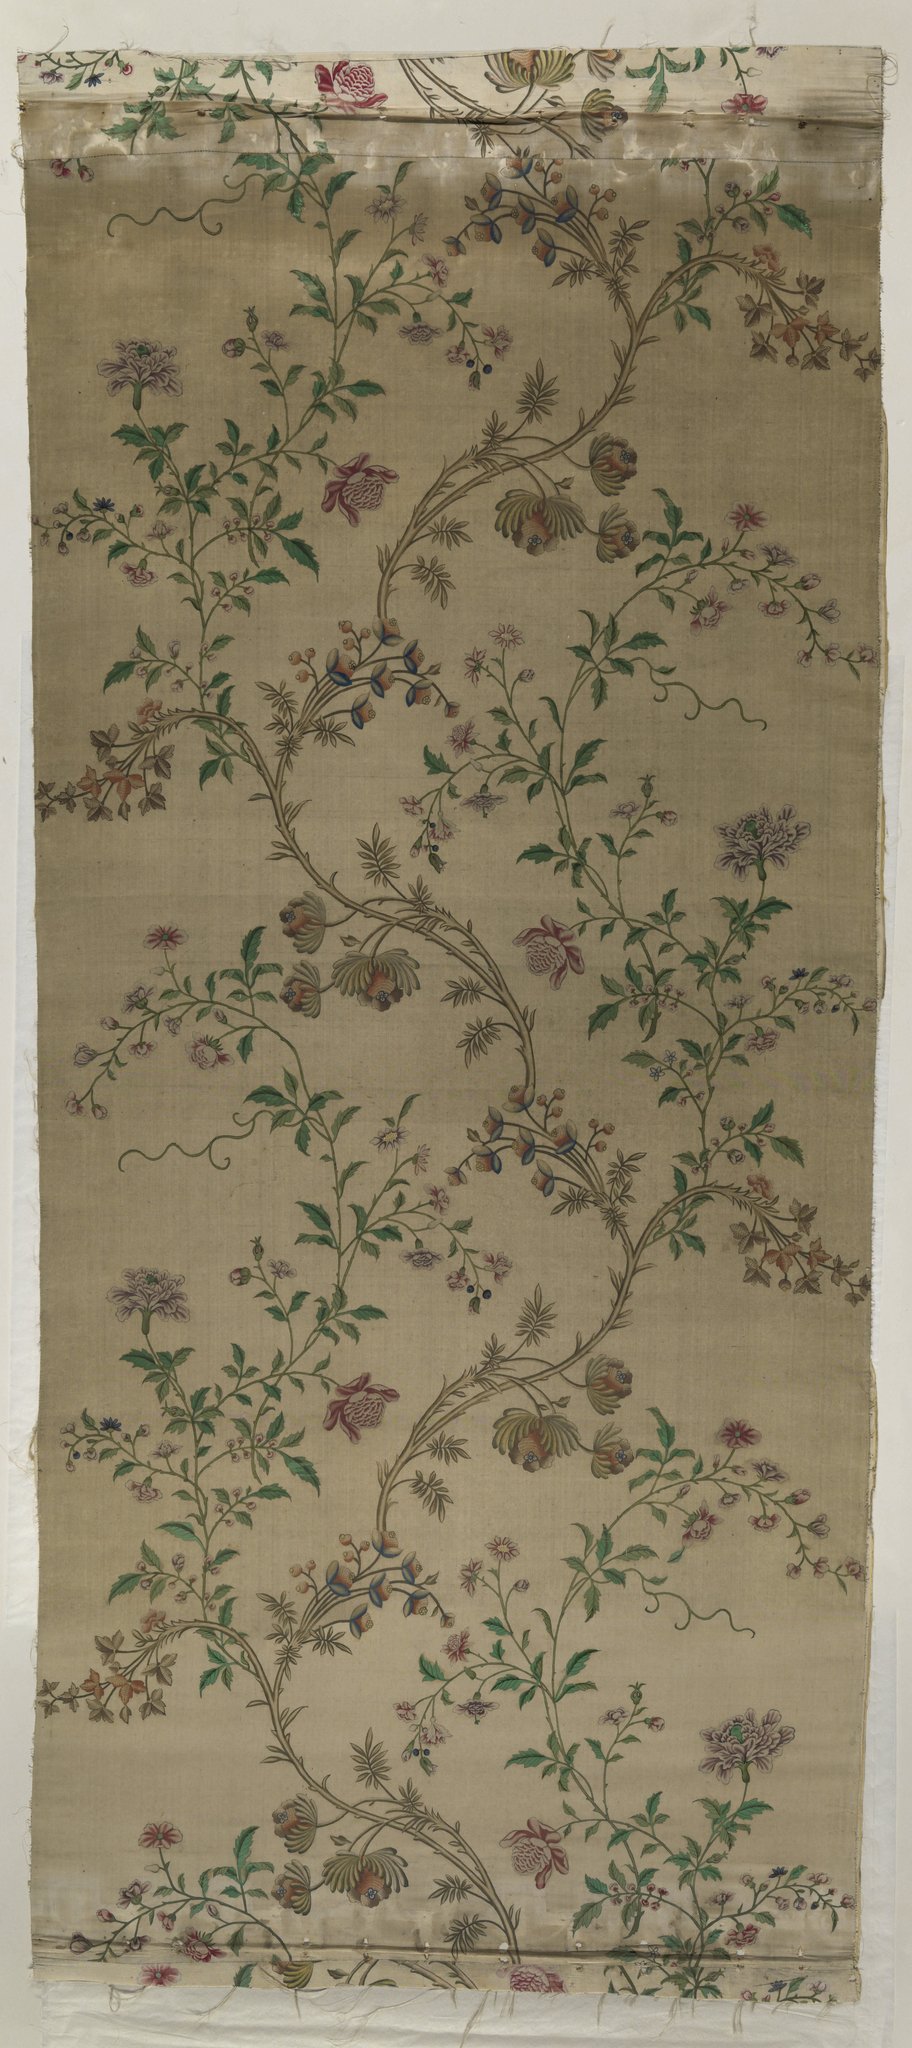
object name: interieuronderdeel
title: Fragment from a length of wall-covering fabric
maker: Anonymous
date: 1750-1790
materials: silk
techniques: weave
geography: china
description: Bespanningsstof: baan crèmekleurige zijde met decor van veelkleurige met de hand ingeschilderde takken, bladeren, bloemen en vruchten in felle kleuren binnen gedrukte contouren.